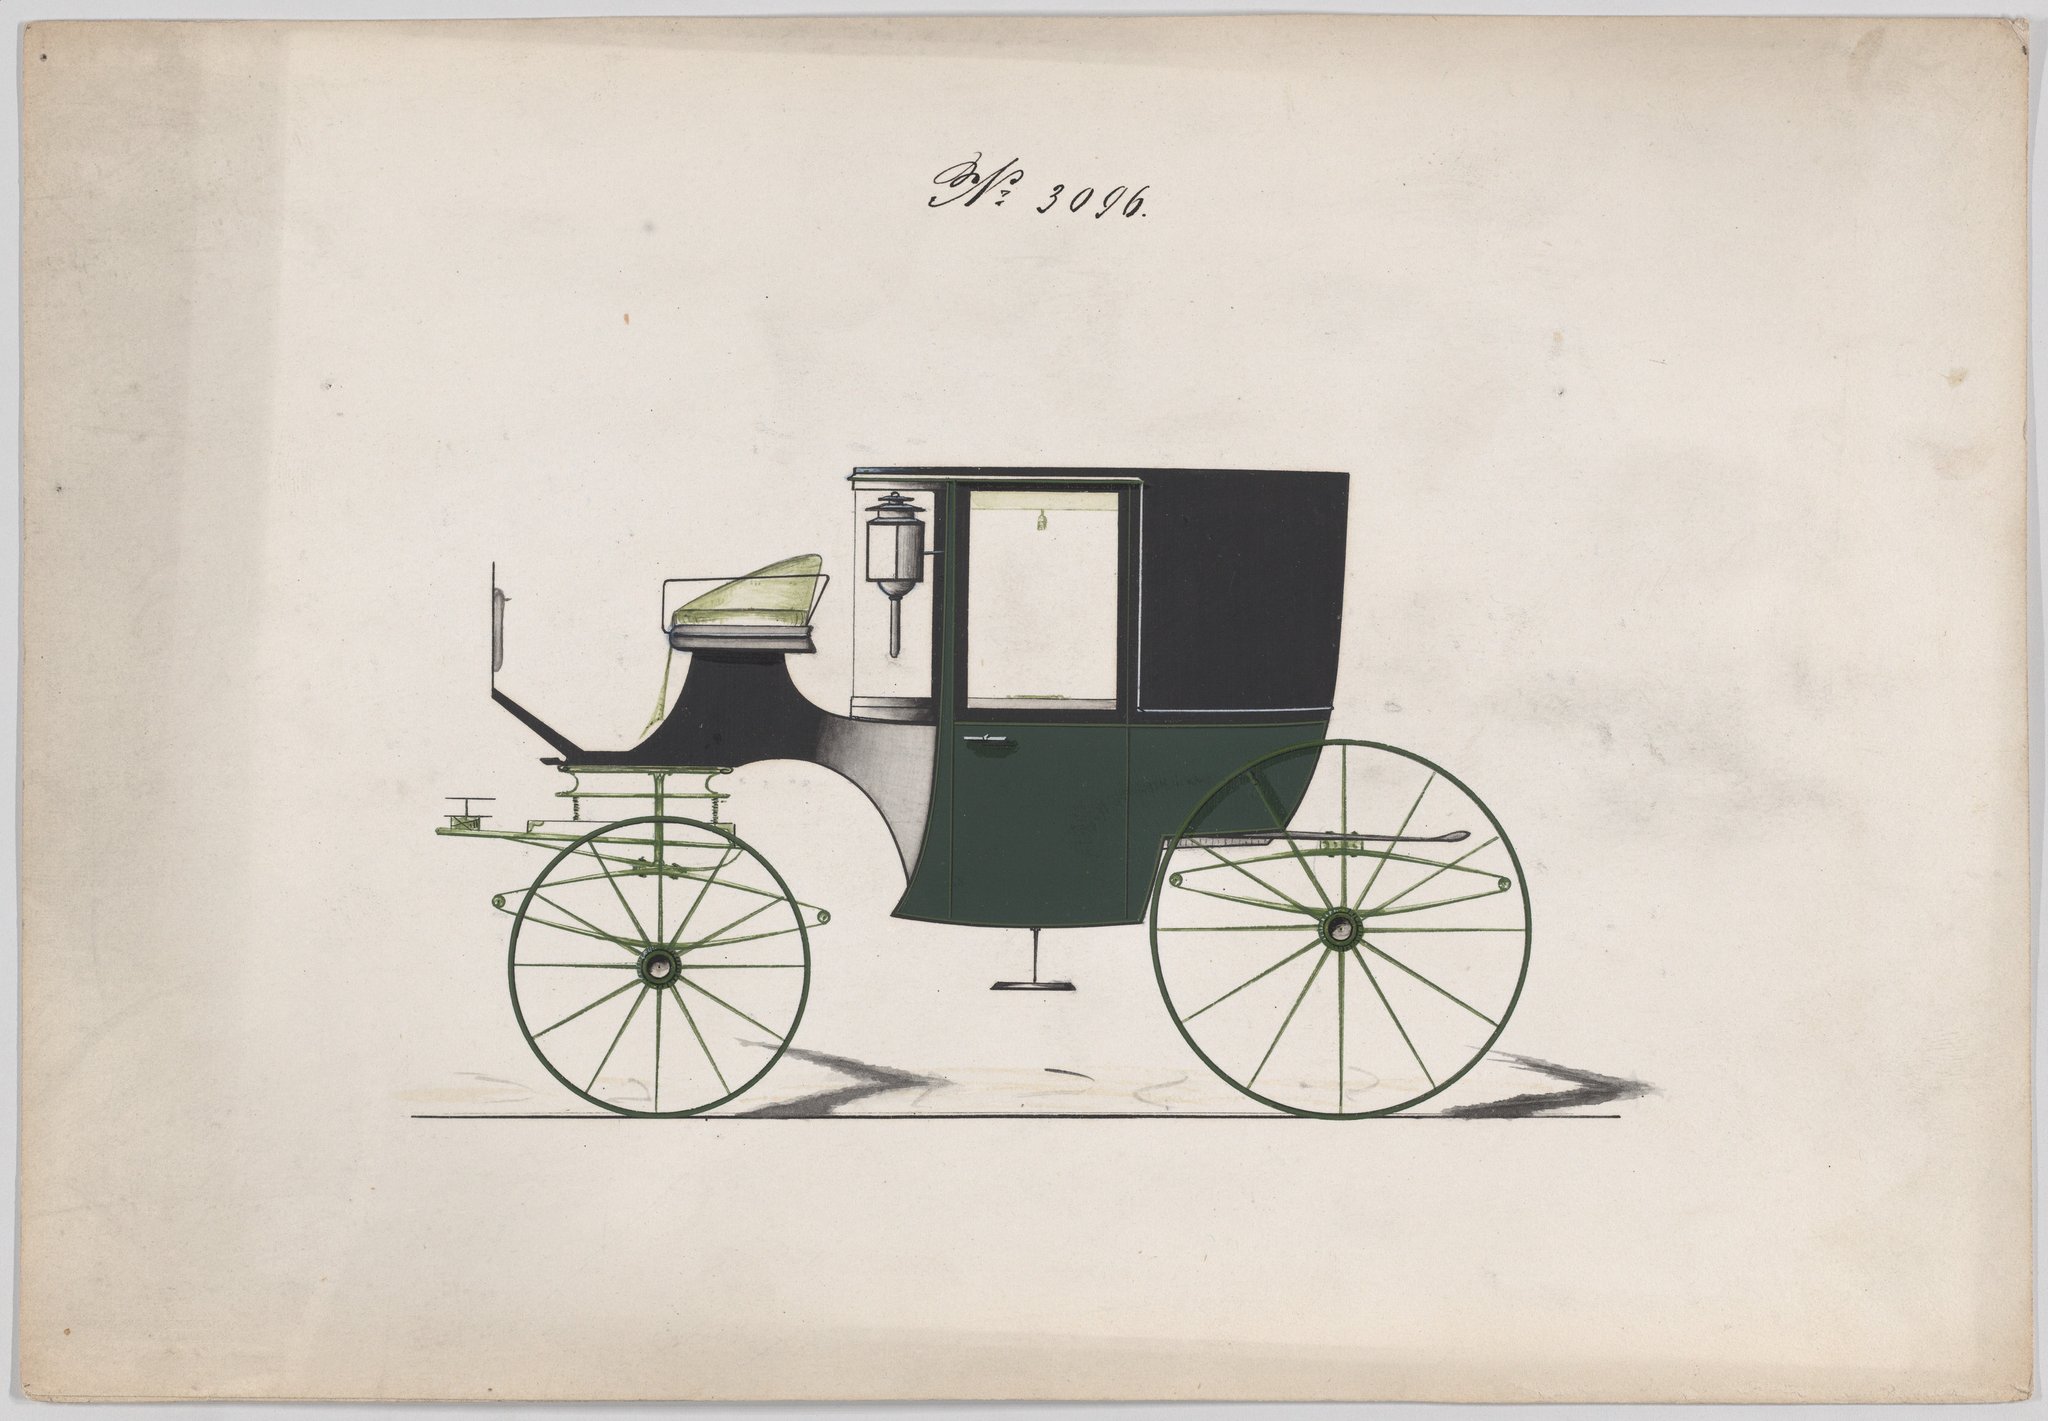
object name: drawing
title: Design for Coupé, no. 3096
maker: brewster & co.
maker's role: manufacturer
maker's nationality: american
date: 1875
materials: gouache, ink, watercolor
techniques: pen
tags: carriages